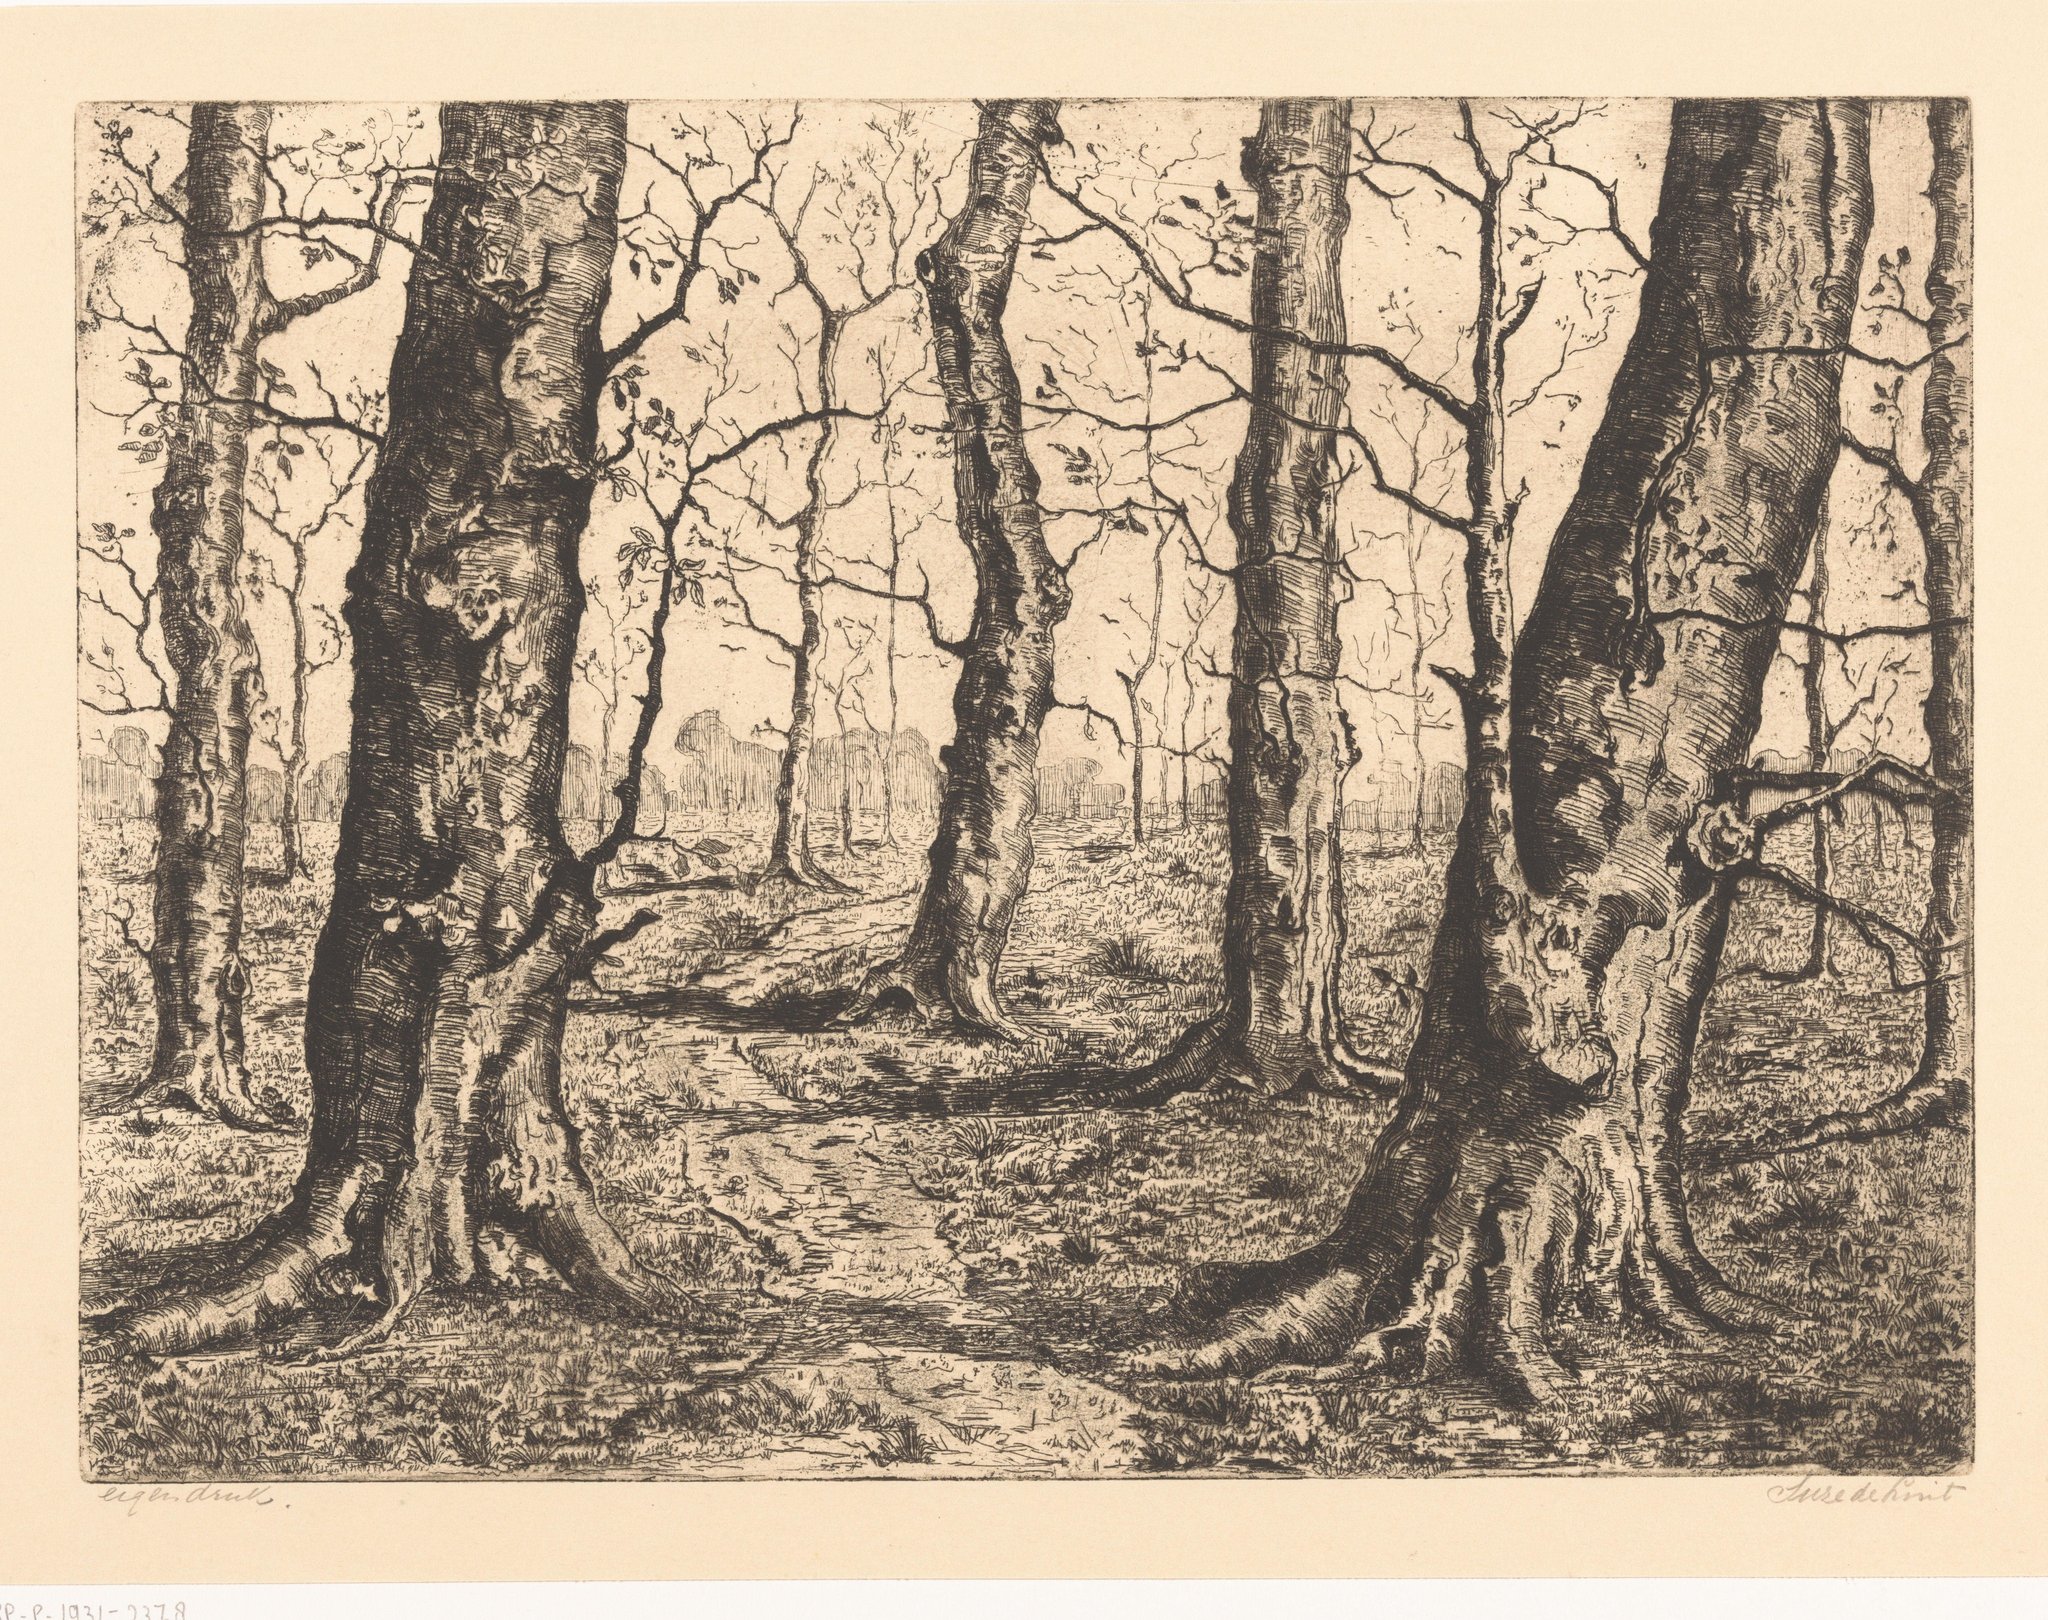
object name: print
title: Bosrand met kale bomen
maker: suze de lint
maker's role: print maker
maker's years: 1878-1953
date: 1888-1931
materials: paper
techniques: etching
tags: forest, wood, forest path or lane, autumn, fall, 'autumnus'; 'autunno' (ripa)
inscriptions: collector's mark: Lugt 2228